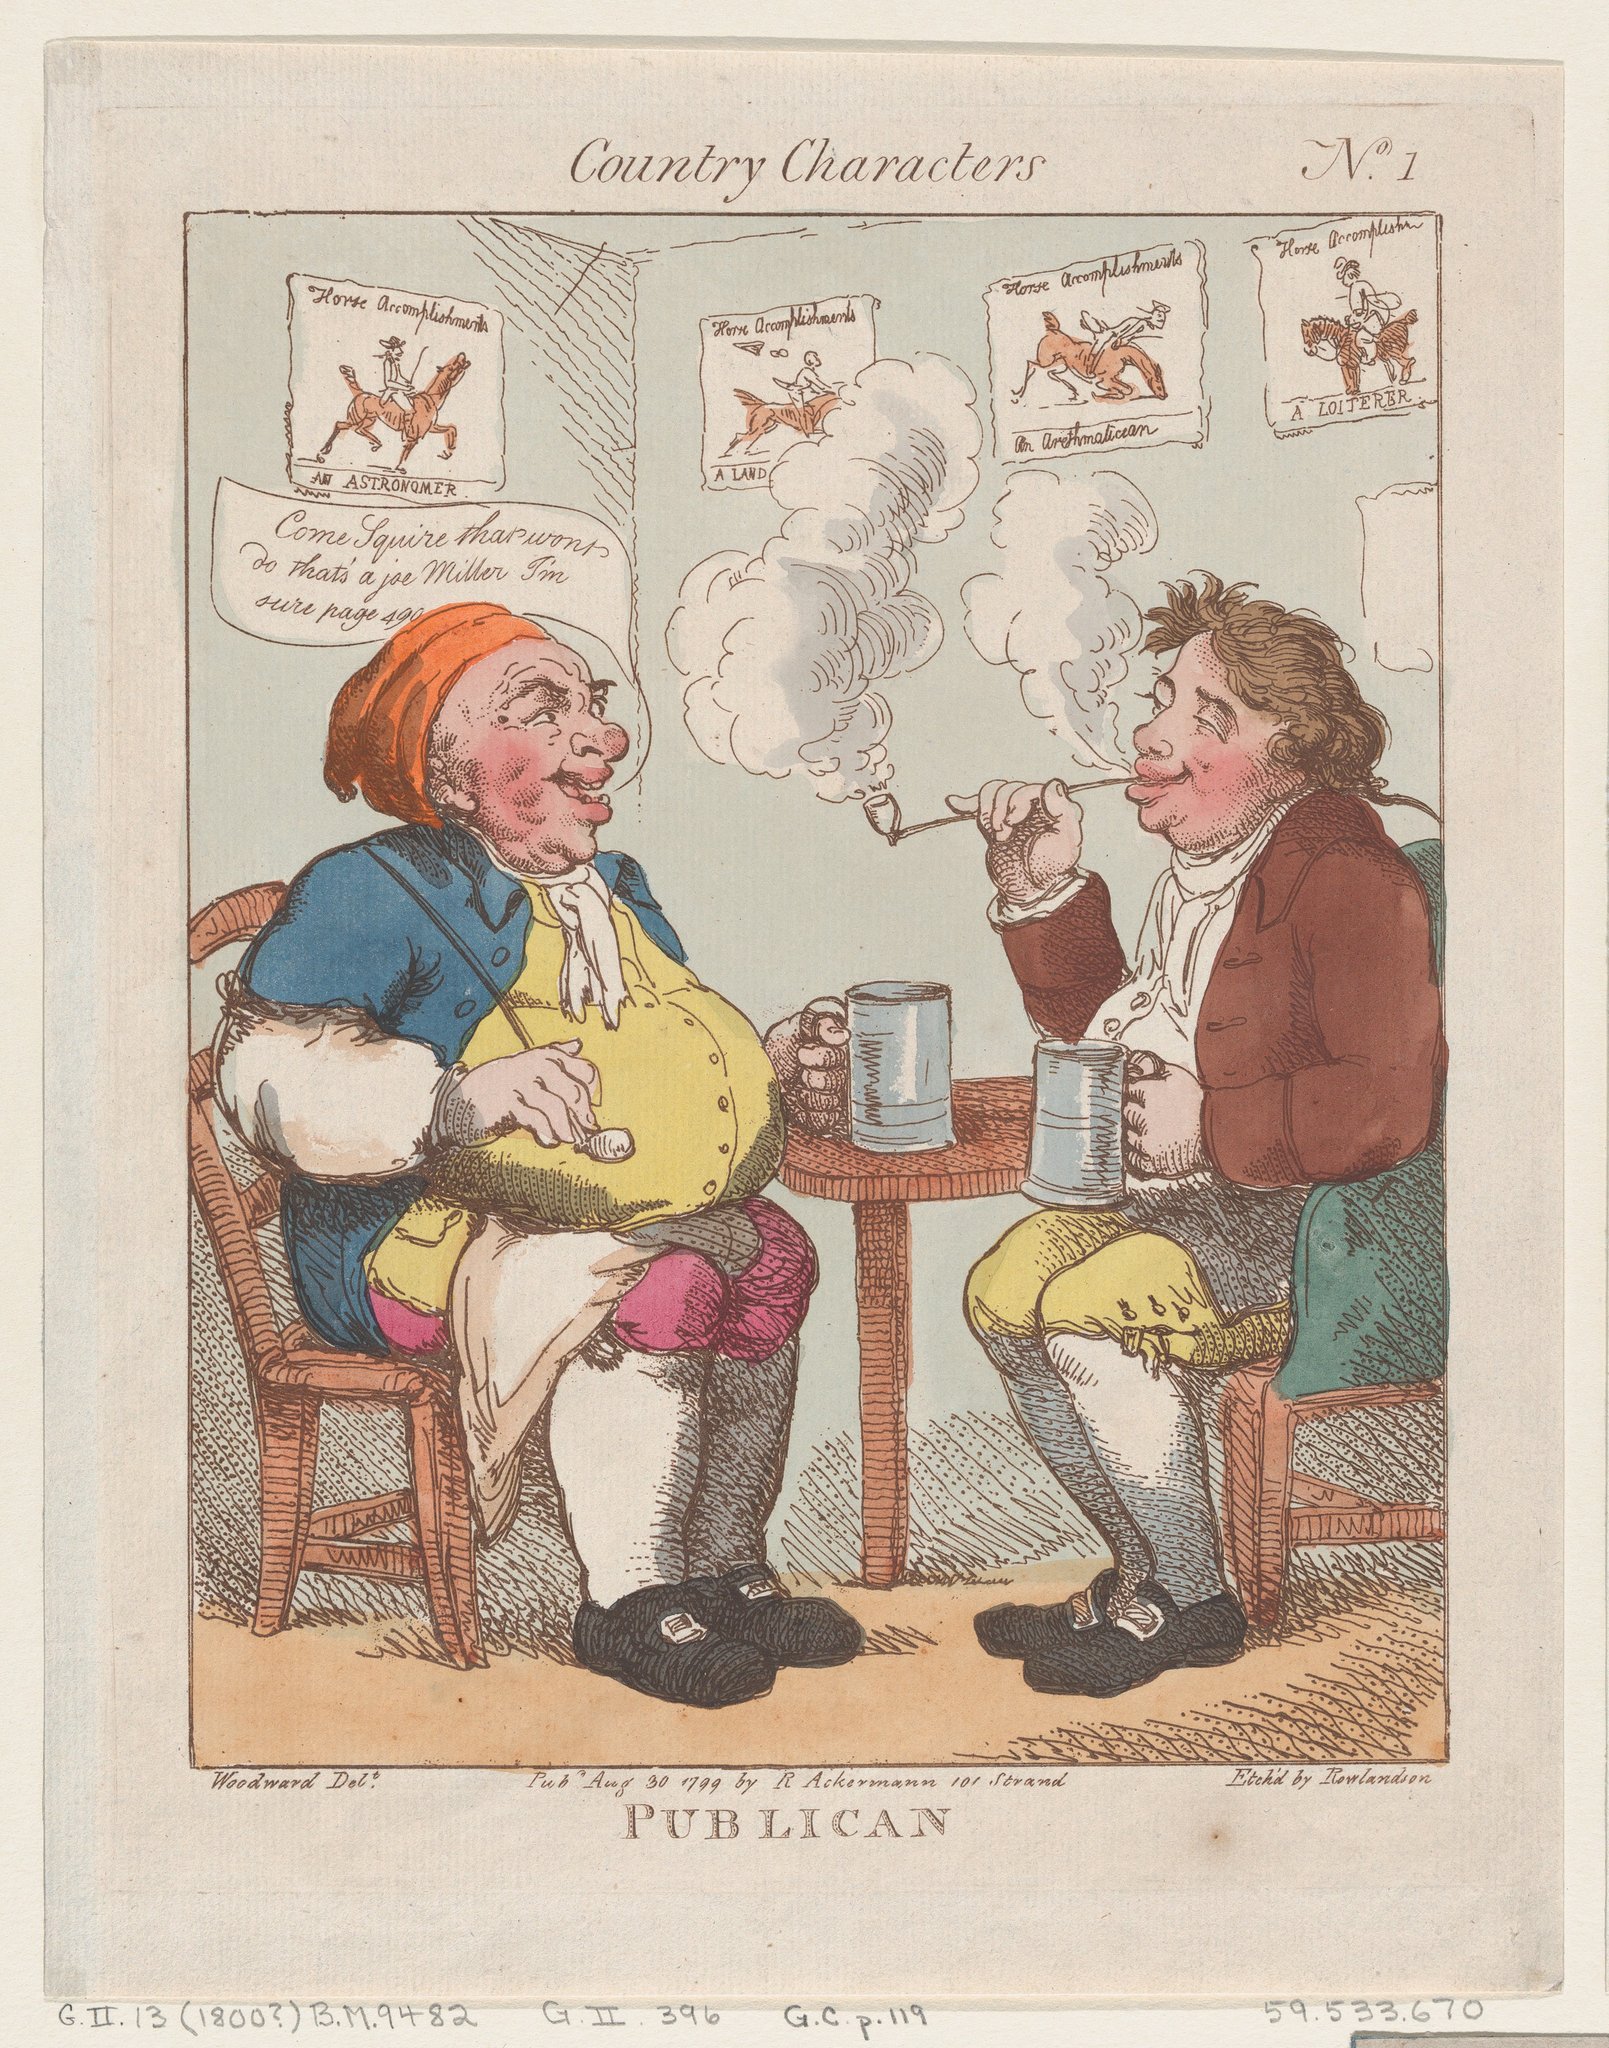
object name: print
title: Publican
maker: thomas rowlandson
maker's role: artist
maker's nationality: british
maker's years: 1757-1827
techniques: etching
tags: men,smoking,drinking